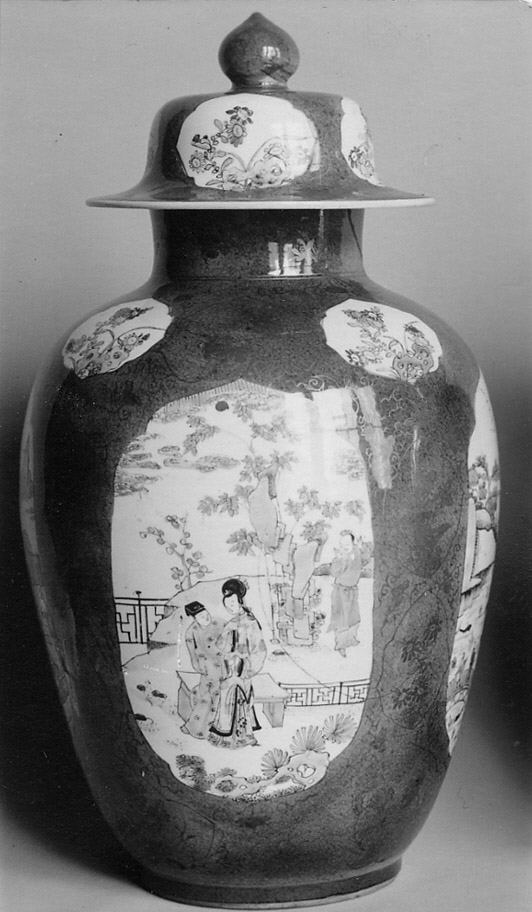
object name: covered jar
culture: chinese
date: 1662-1722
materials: enamel, porcelain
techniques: painting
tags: men,women,trees